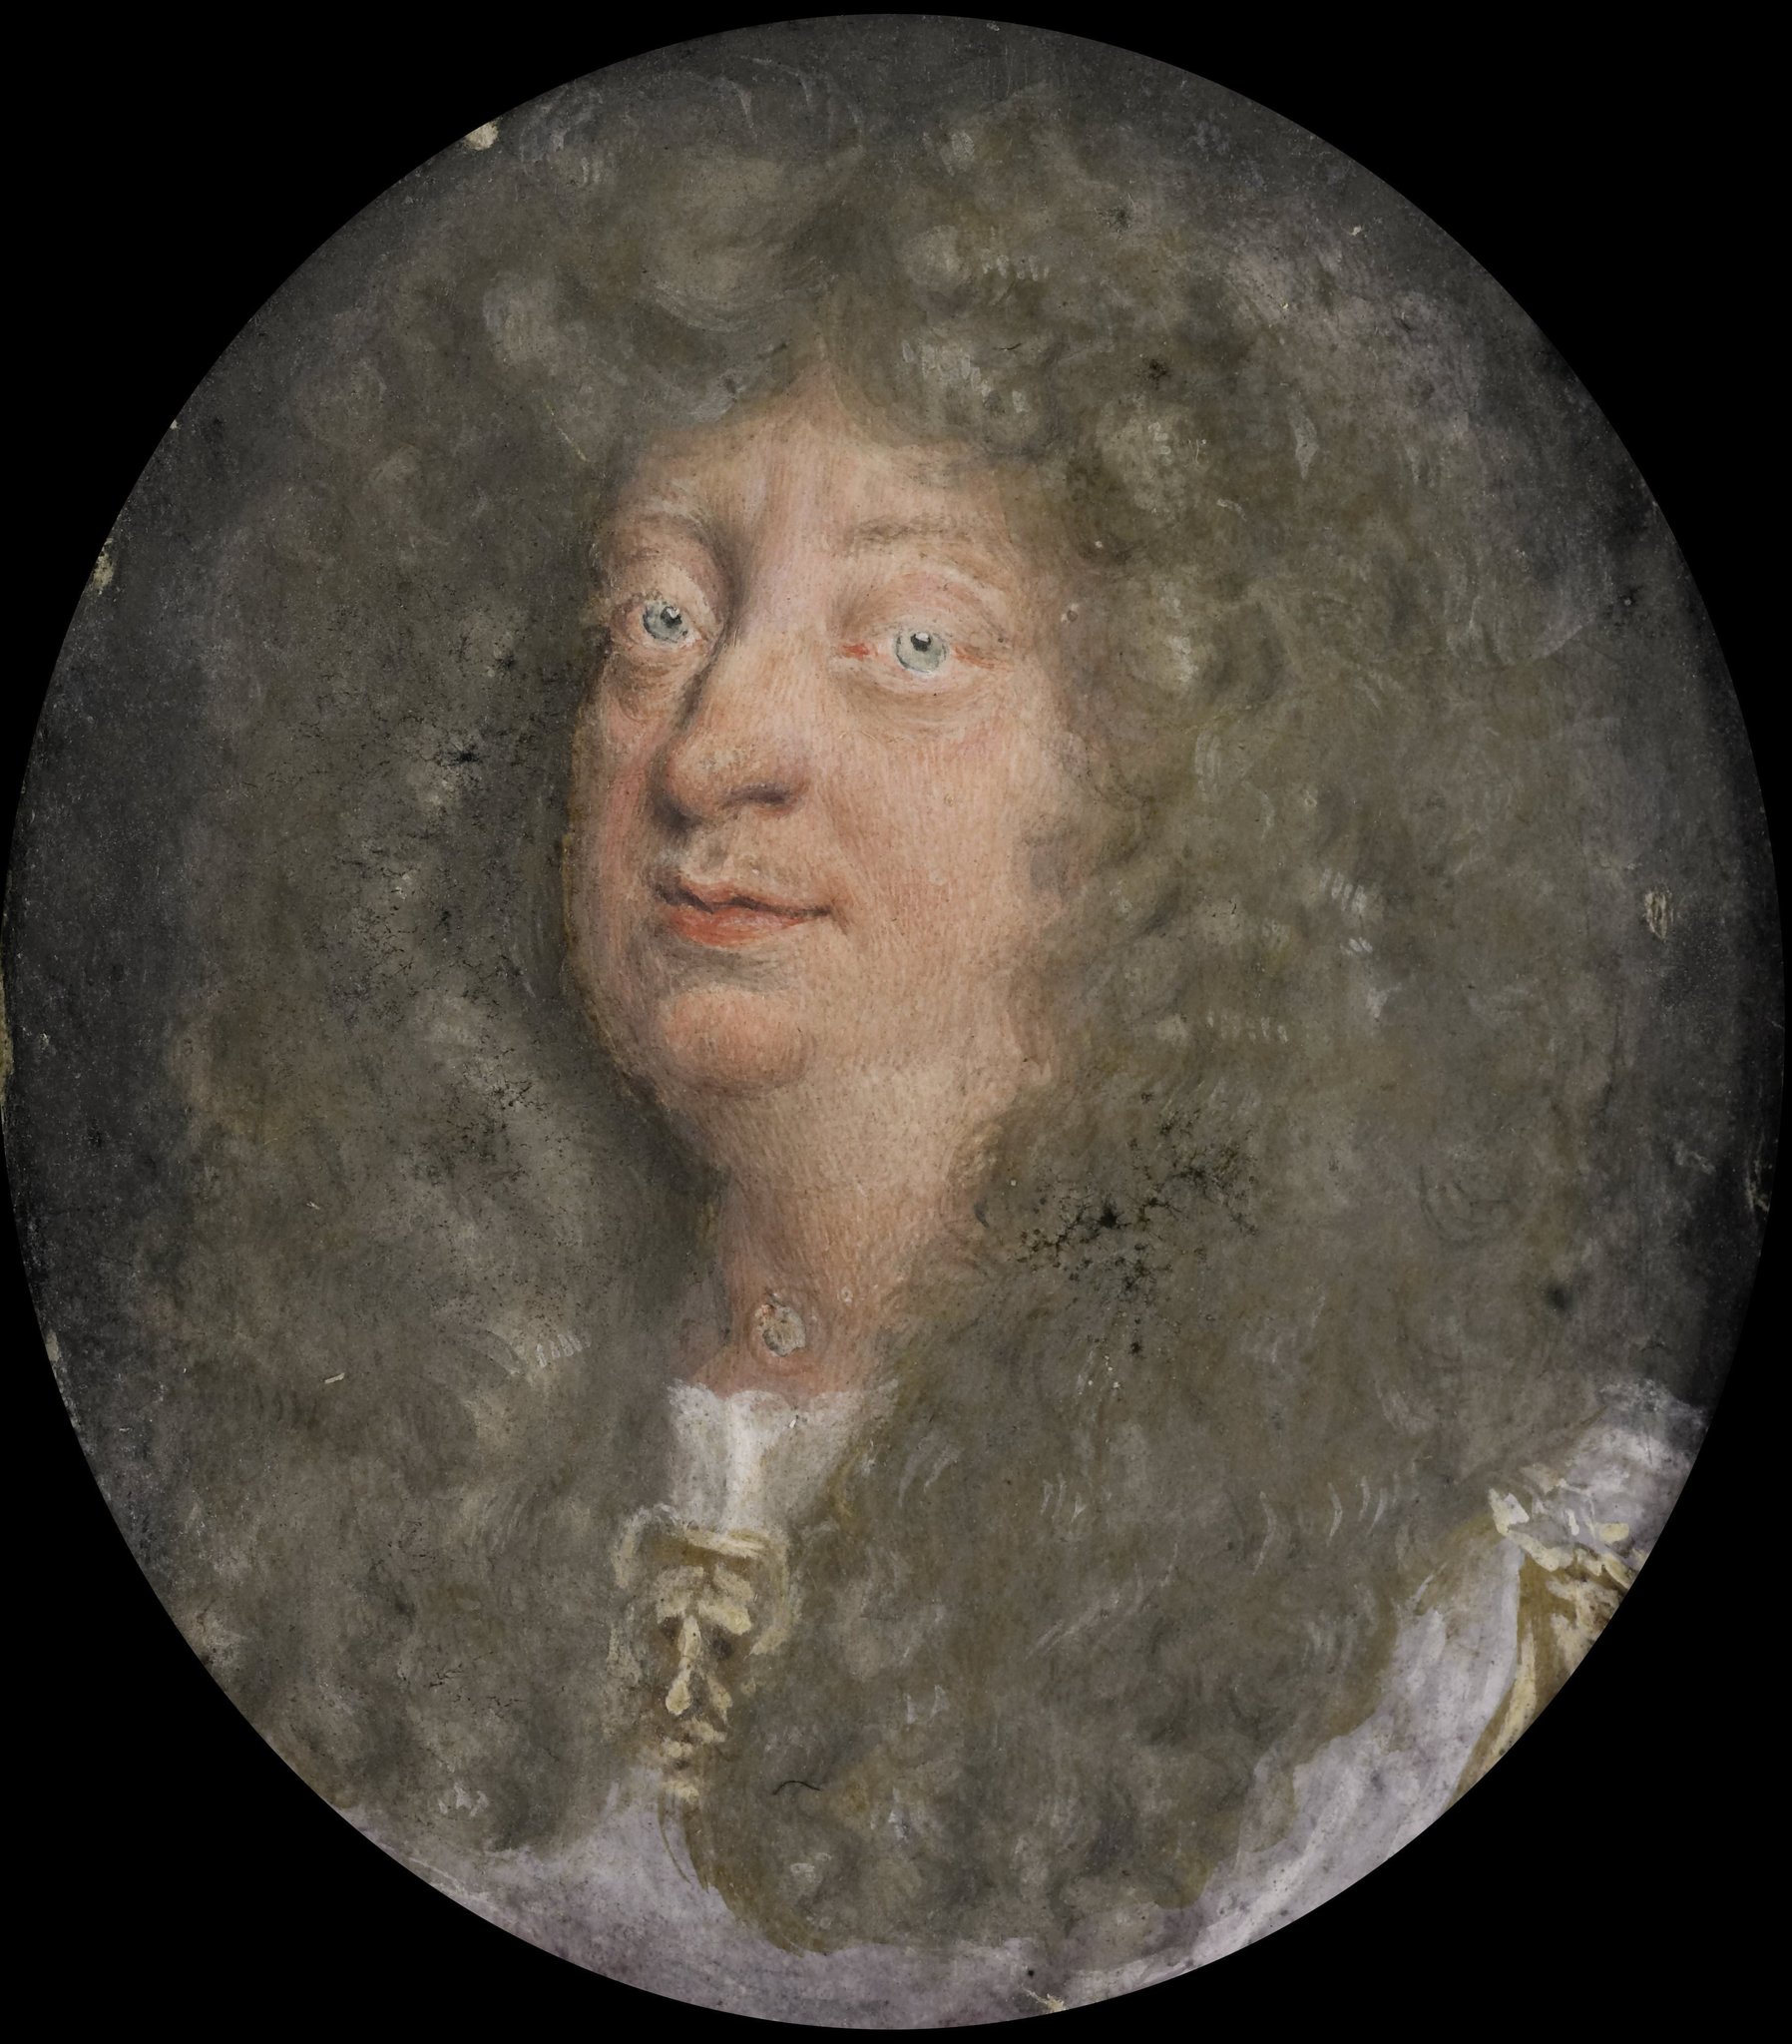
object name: painting, miniature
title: Georg Wilhelm (1625-1705), hertog van Brunswijk-Luneburg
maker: jean michelin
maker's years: 1623-1695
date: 1674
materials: cardboard, glass, metal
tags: georg willem hertog van brunswijk-lüneburg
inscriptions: signature and date: ‘Michelin fecit 1674’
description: Portret van Georg Wilhelm (1625-1705), hertog van Brunswijk-Luneburg. Buste, naar links. Onderdeel van de collectie portretminiaturen.